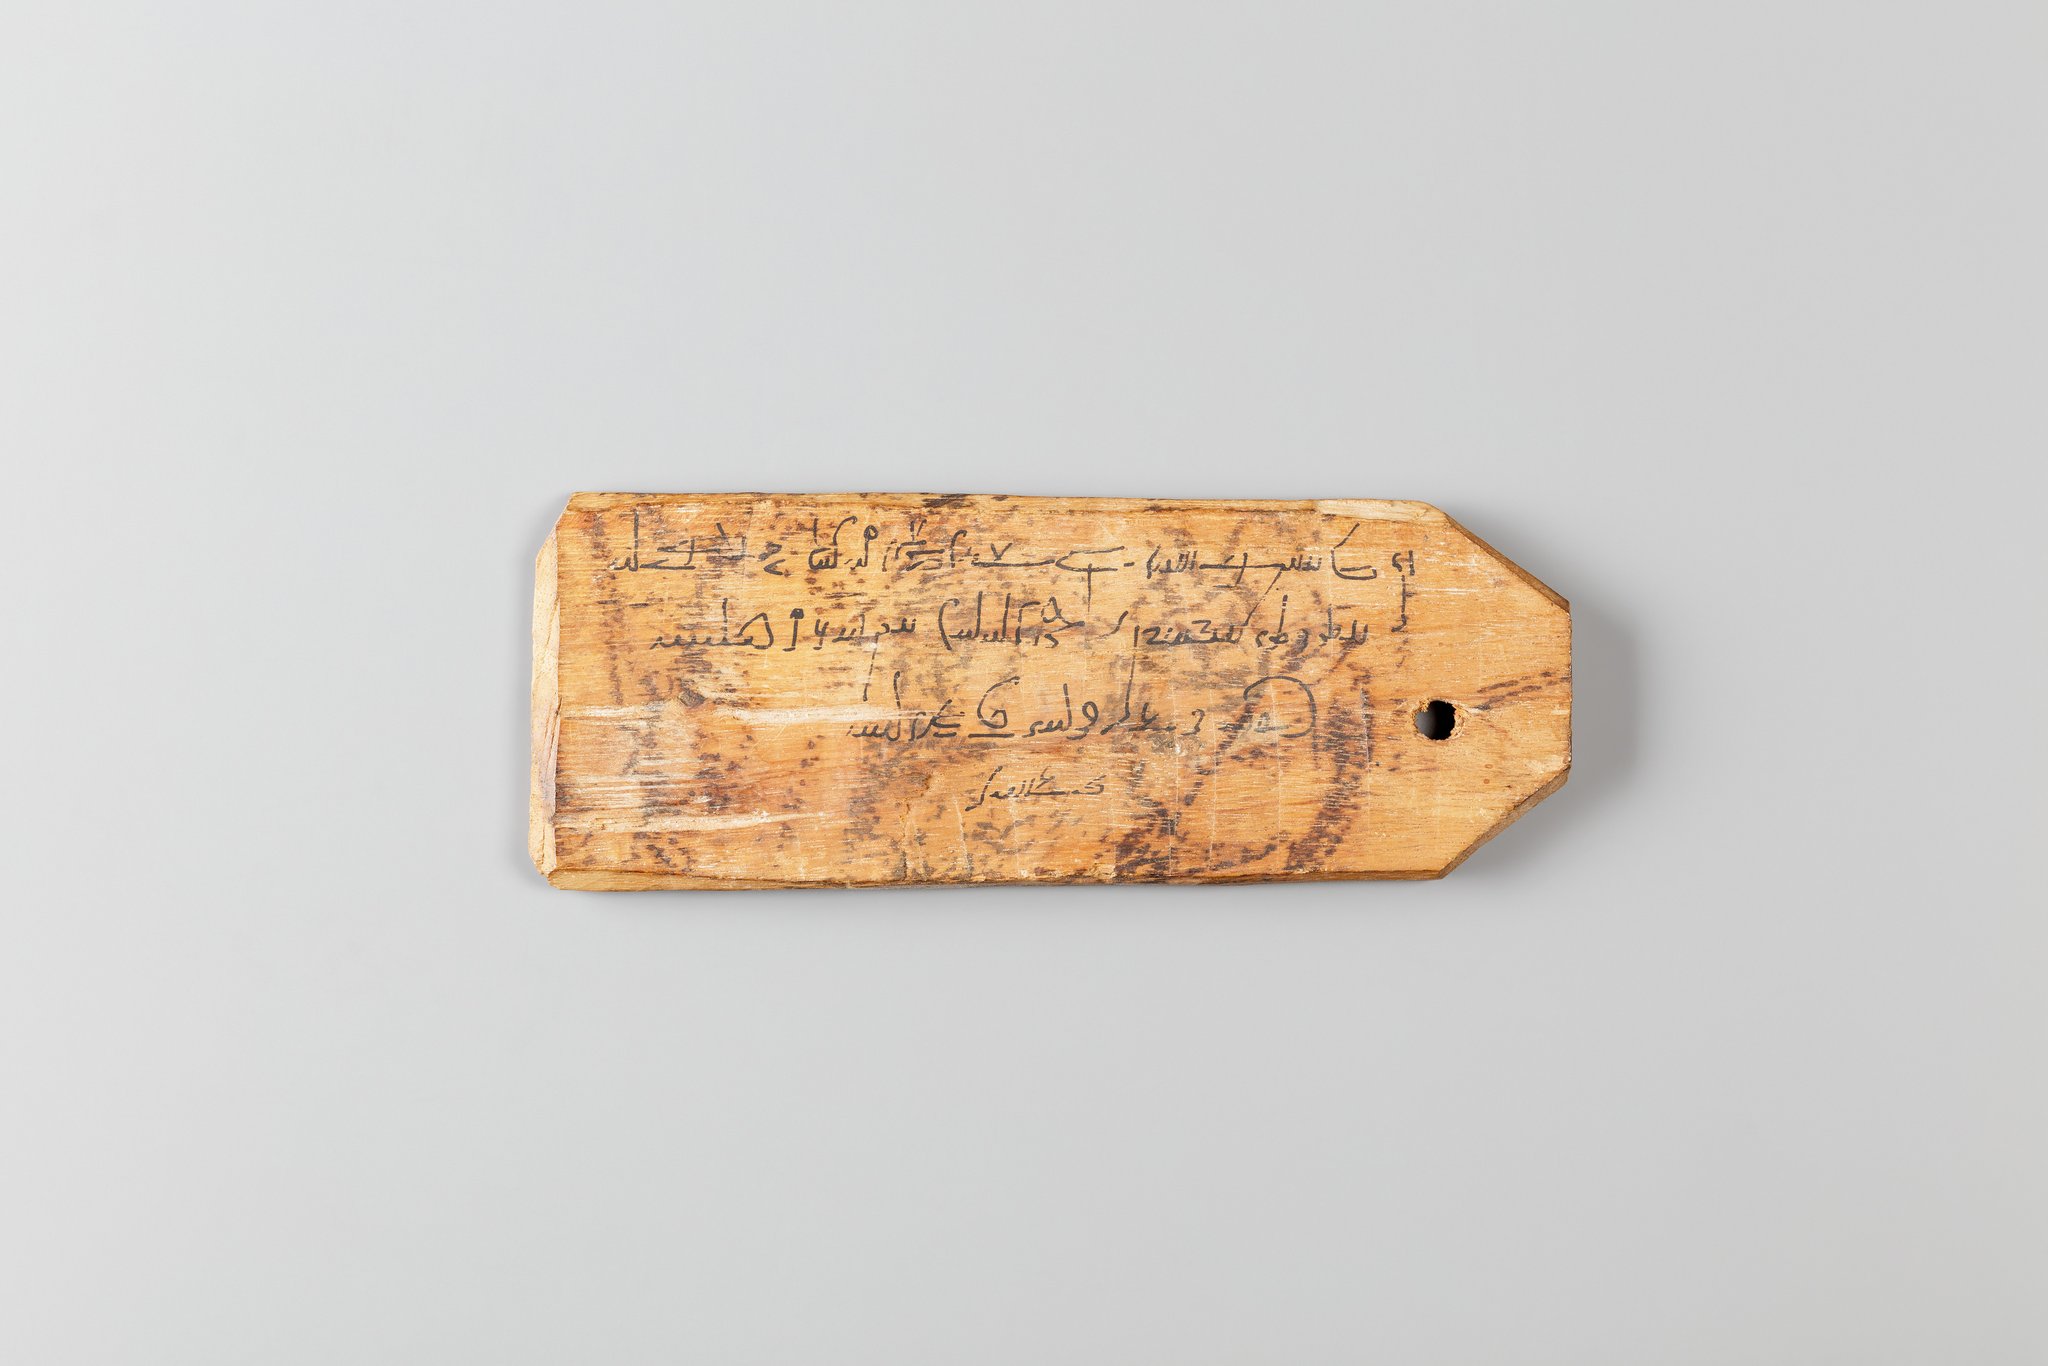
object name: mummy label, psentsenpshay, son of thoteu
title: Mummy Tag of Psentsenpshay, son of Thoteu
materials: ink, wood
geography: northern upper egypt